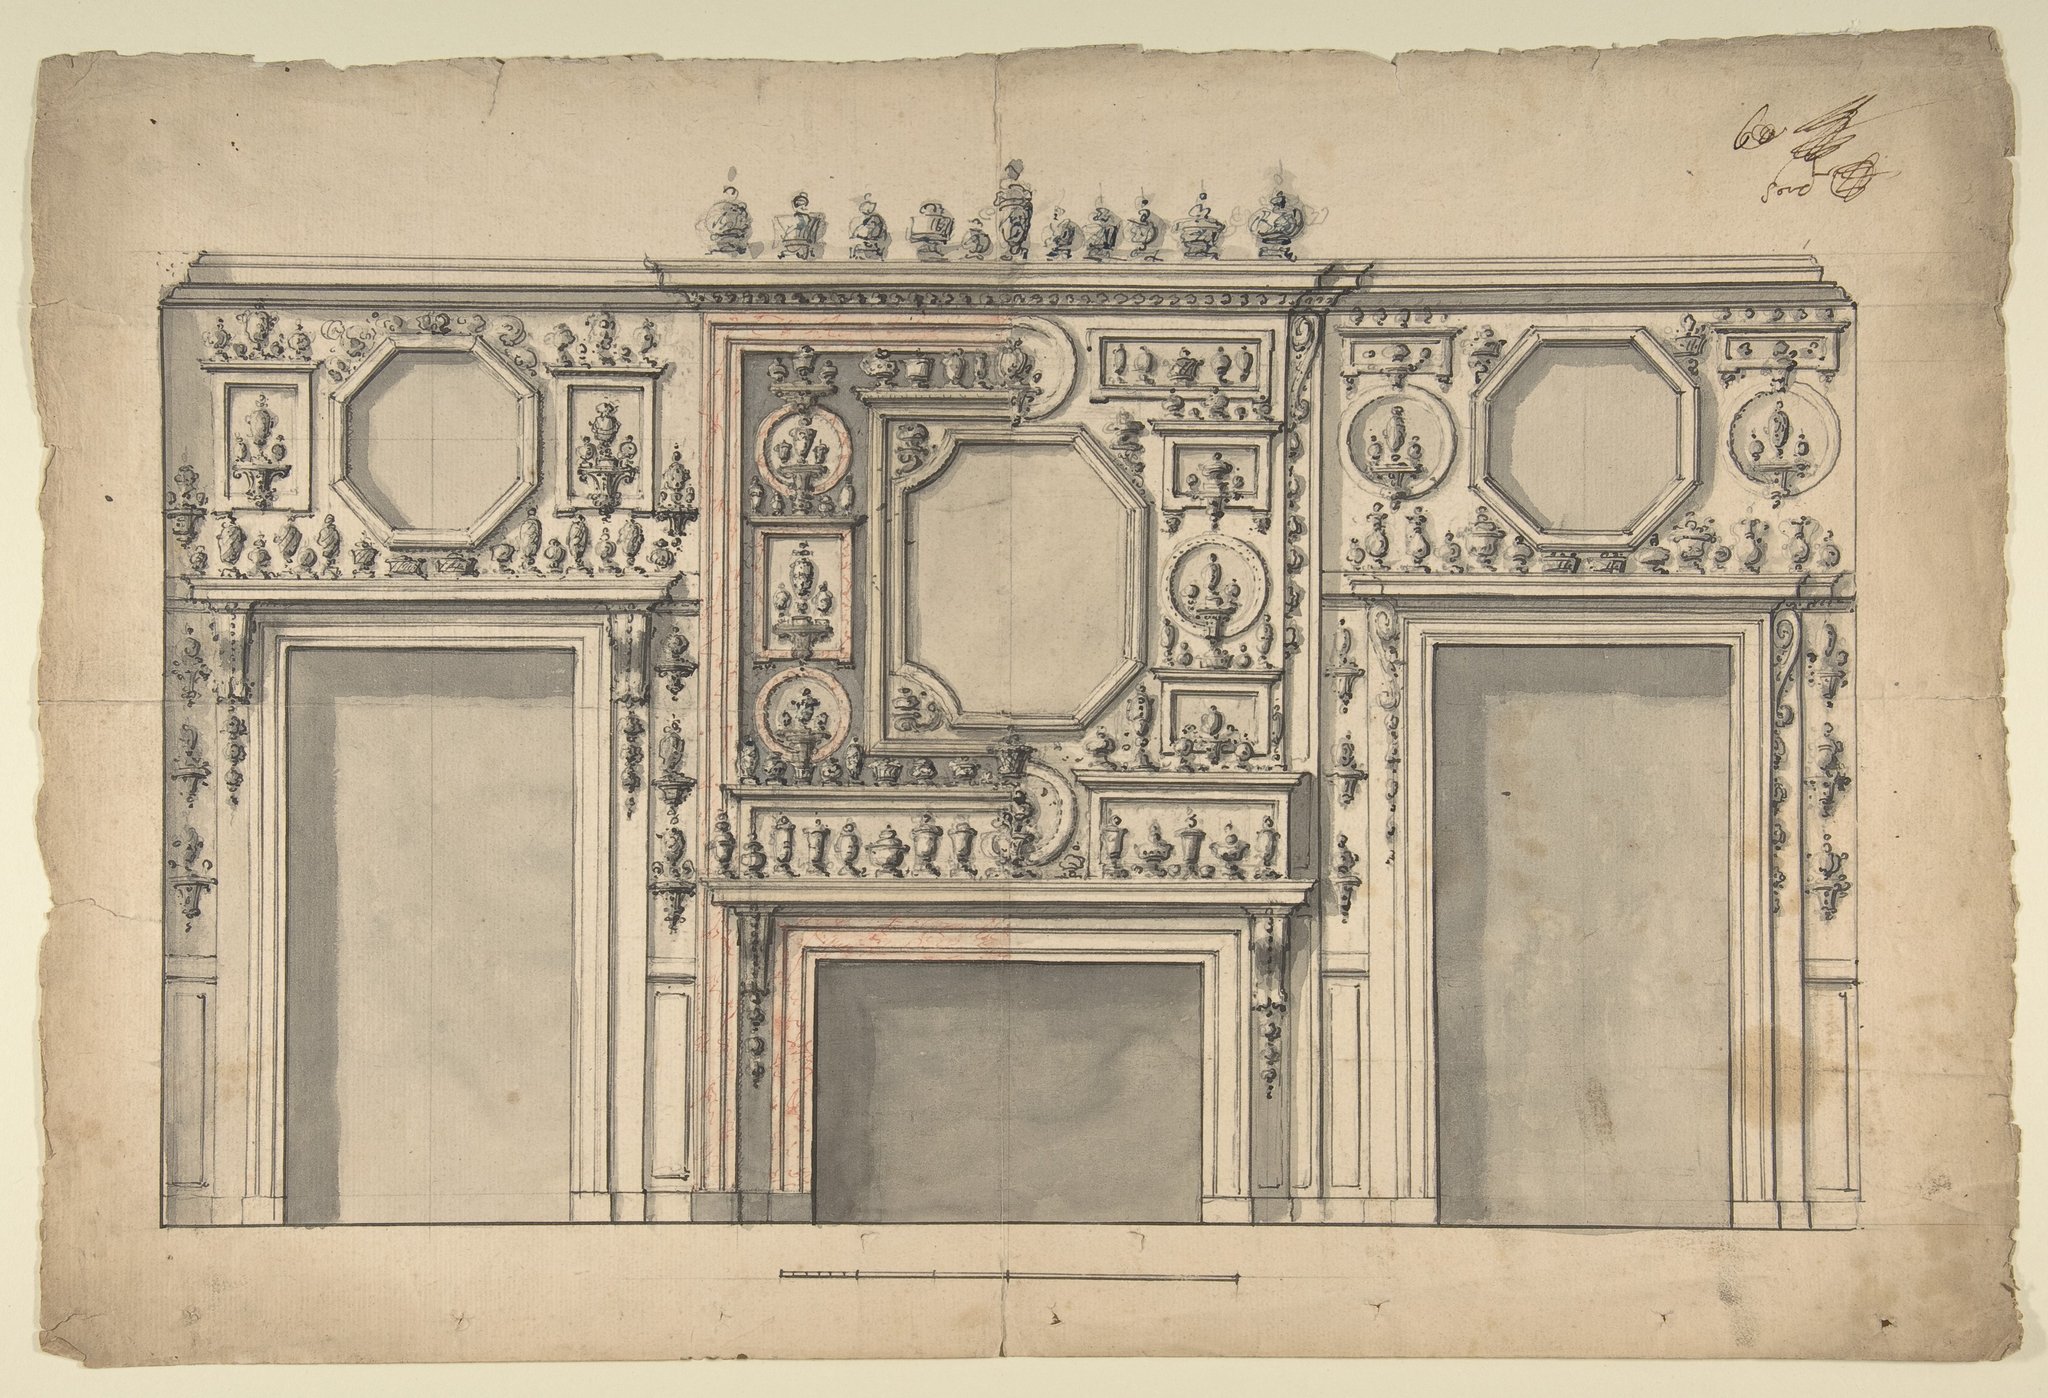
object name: drawing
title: Two Variant Designs for the Interior of a Room, Decorated with Porcelains, Fireplace in Center, and With the Doorways at Either Side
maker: anonymous, italian, 18th century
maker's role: artist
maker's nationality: italian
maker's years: 1700-1800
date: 1701-1800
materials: graphite, ink, paper, lead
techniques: brush, drawing, pen, wash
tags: doorways,interiors